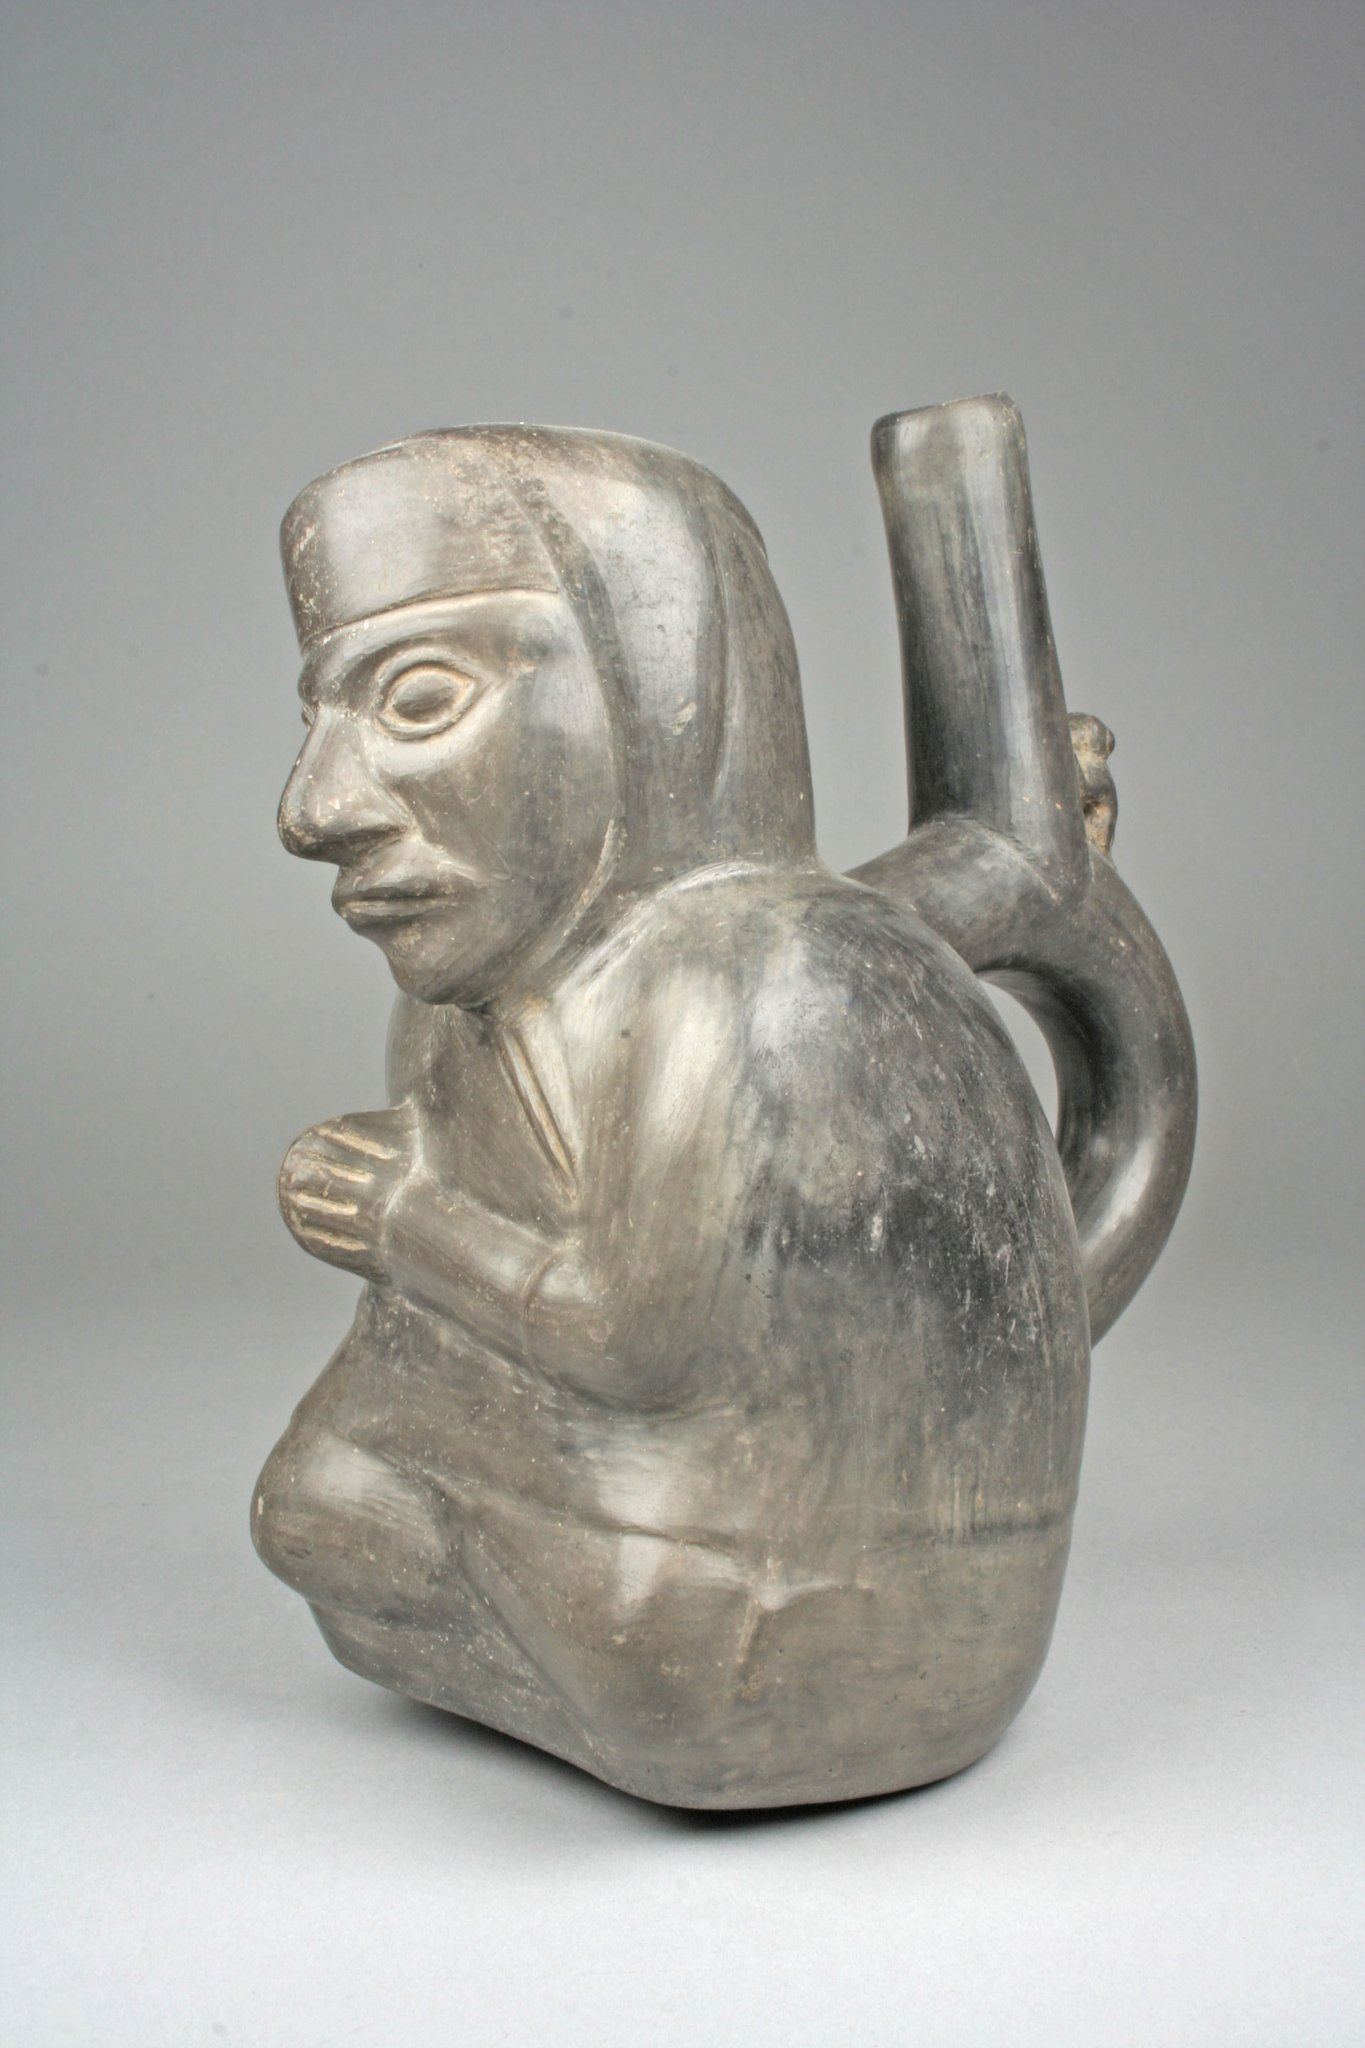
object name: bottle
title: Seated Figure Bottle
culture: chimú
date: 1101-1500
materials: ceramic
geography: peru